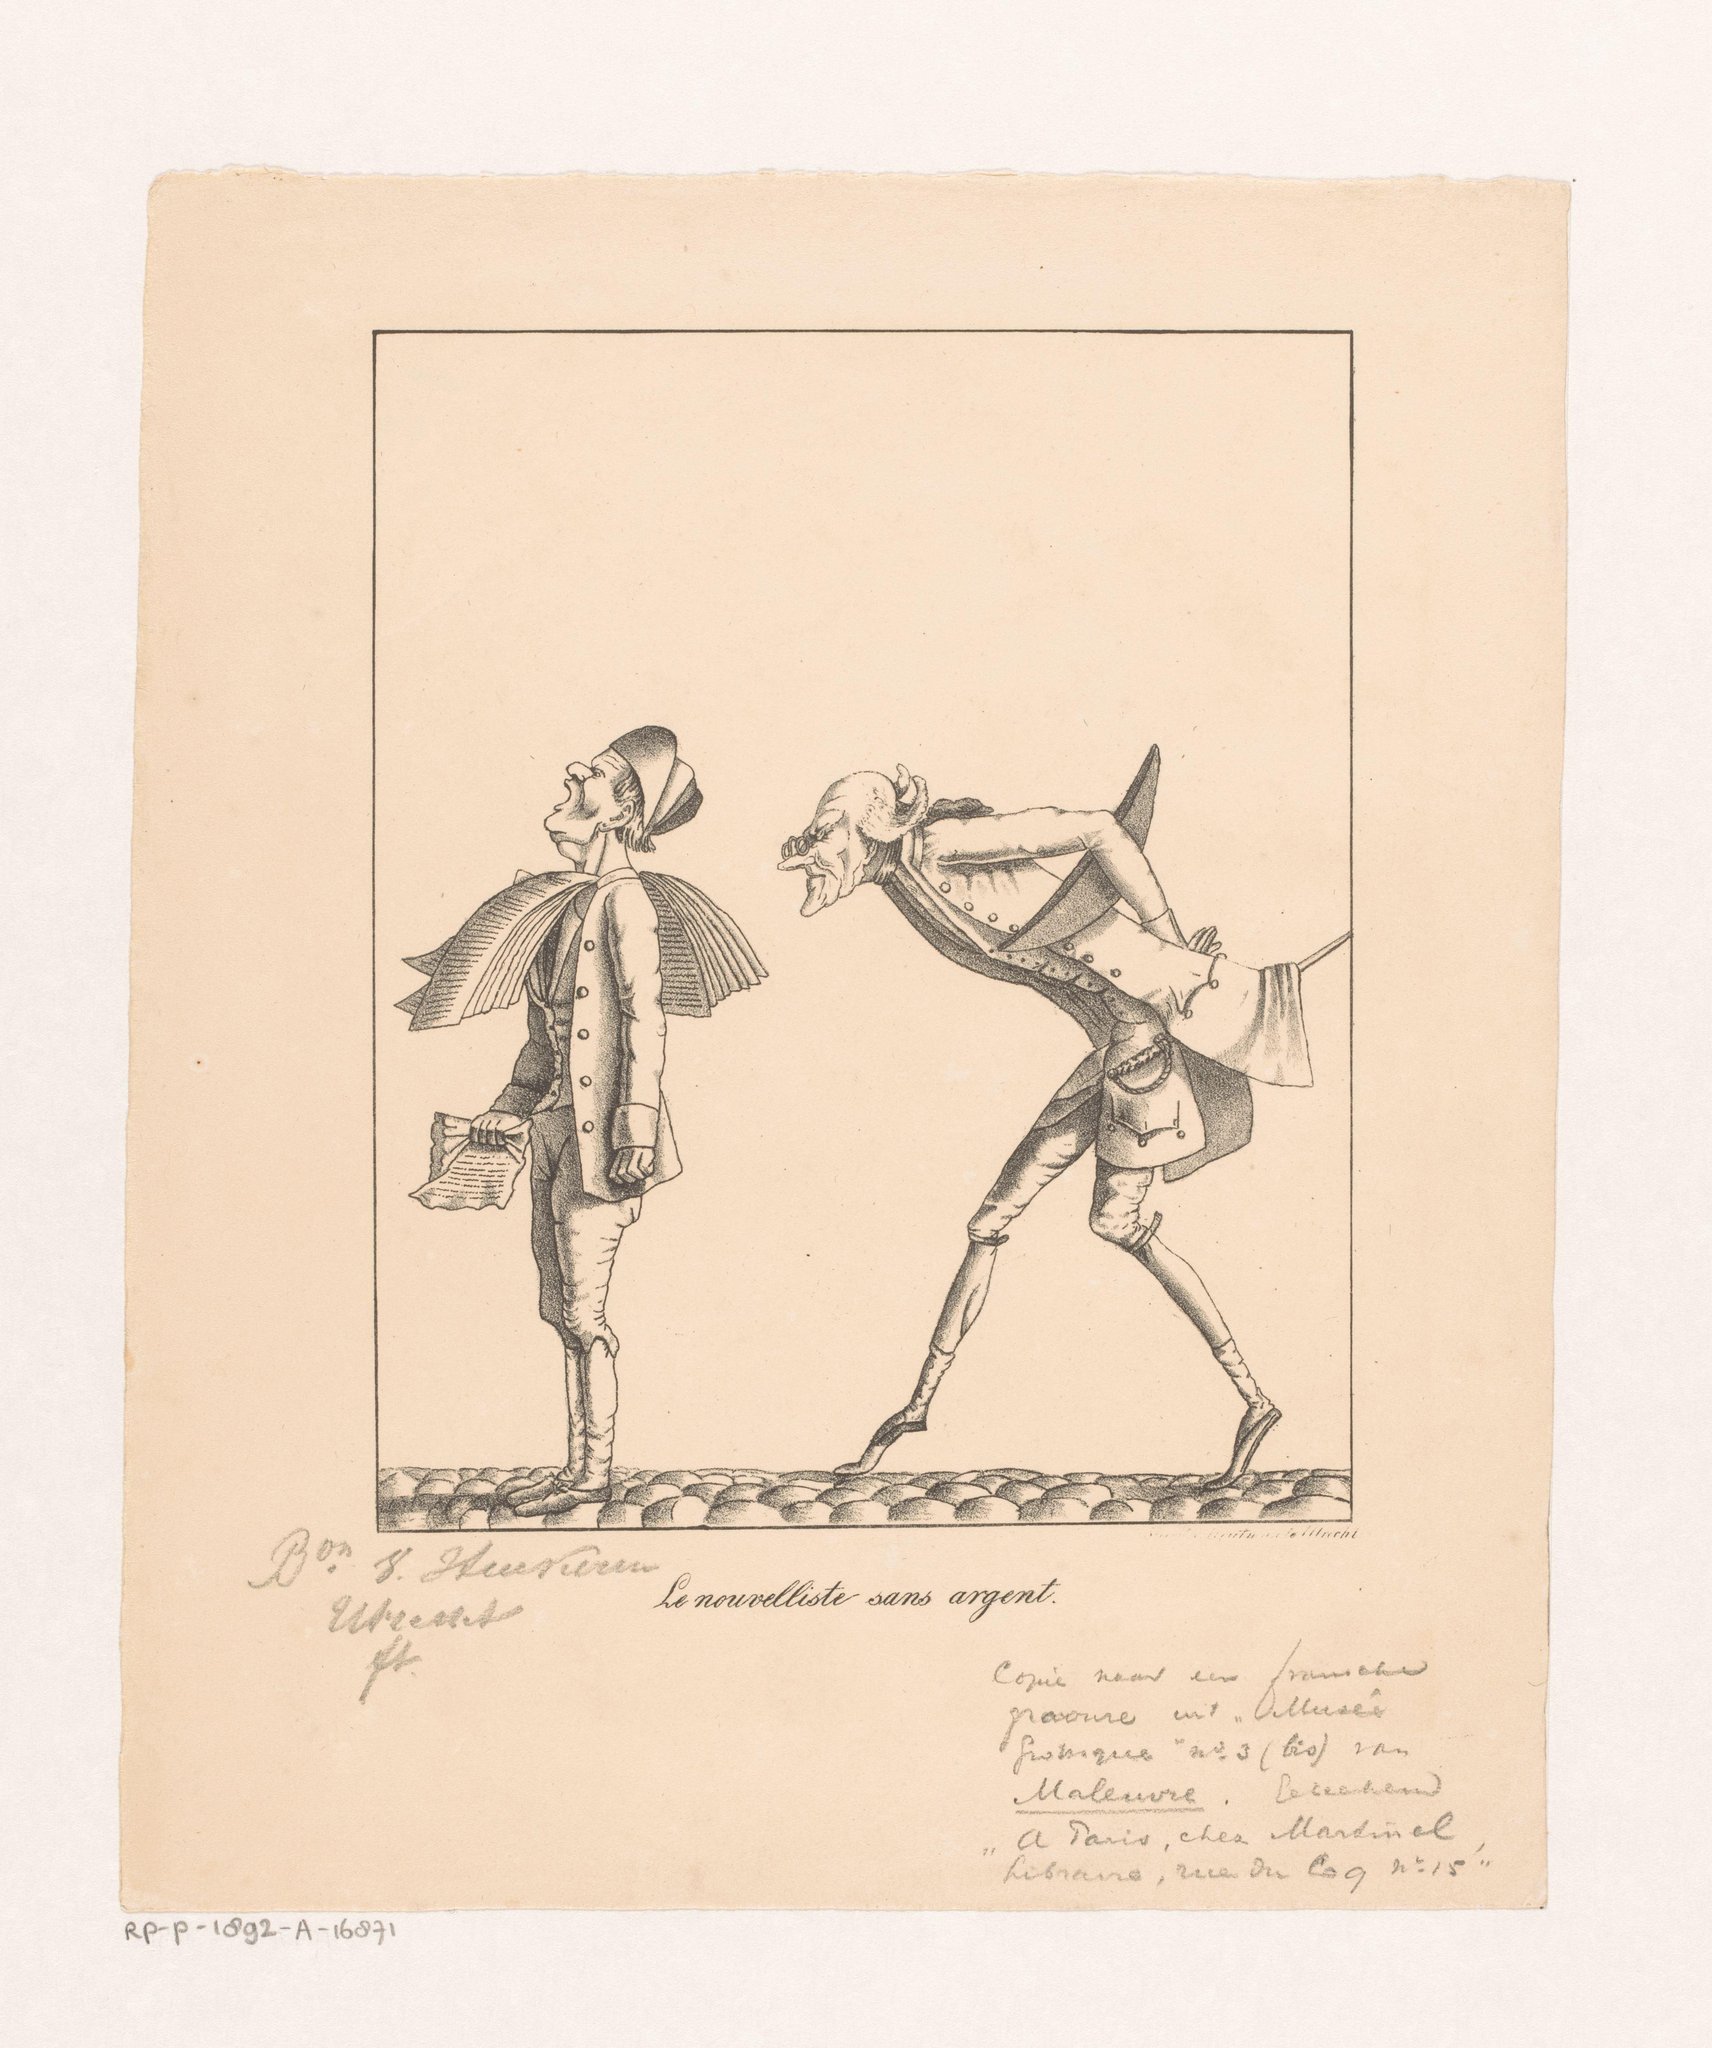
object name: print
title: Man probeert de krant te lezen van de rug van een krantenjongen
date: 1814-1846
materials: paper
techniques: lithograph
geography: paris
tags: reading, newsboy, newsman, caricatures (human types), newspaper, news-sheet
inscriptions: collector's mark: Lugt 2228, inscription: ‘Bar F. Heeckeren / Utrecht / ft.’, inscription: ‘Copie naar een fransche / gravure uit "Musée / grotesque" no. 3 (bis) van / Maleuvre. Getekend / "A Paris, chez Martinet / Li(...), rue du Coq no. 15"’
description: Deze prent is een kopie naar een prent uit 'Musée Grotesque'. Dit was een serie satirische prenten die bestond uit minstens 65 prenten, gepubliceerd in Parijs tussen 1814 en 1829 en uitgegeven door Aaron Martinet. Deze prent, nummer 3 uit de serie, werd mogelijk ontworpen door Pierre Maleuvre in 1814.